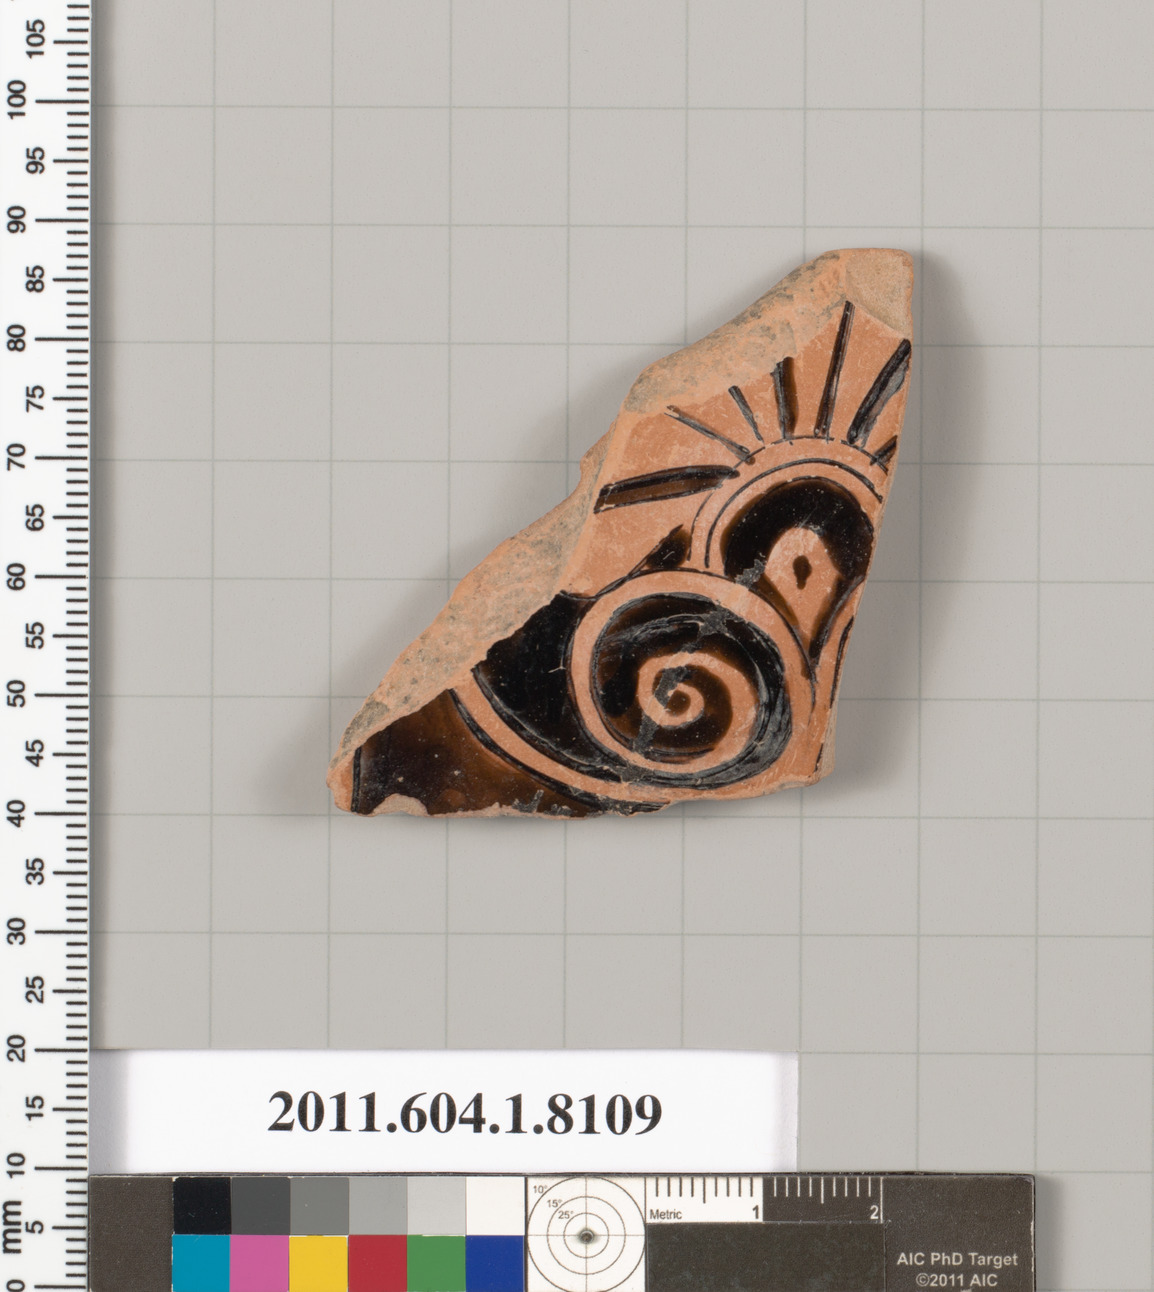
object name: kylix fragment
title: Terracotta fragment of a kylix (drinking cup)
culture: greek, attic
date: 534-468 BCE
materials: terracotta